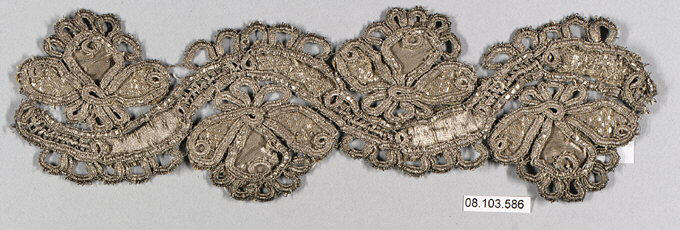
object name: galloon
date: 1601-1800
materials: metal thread